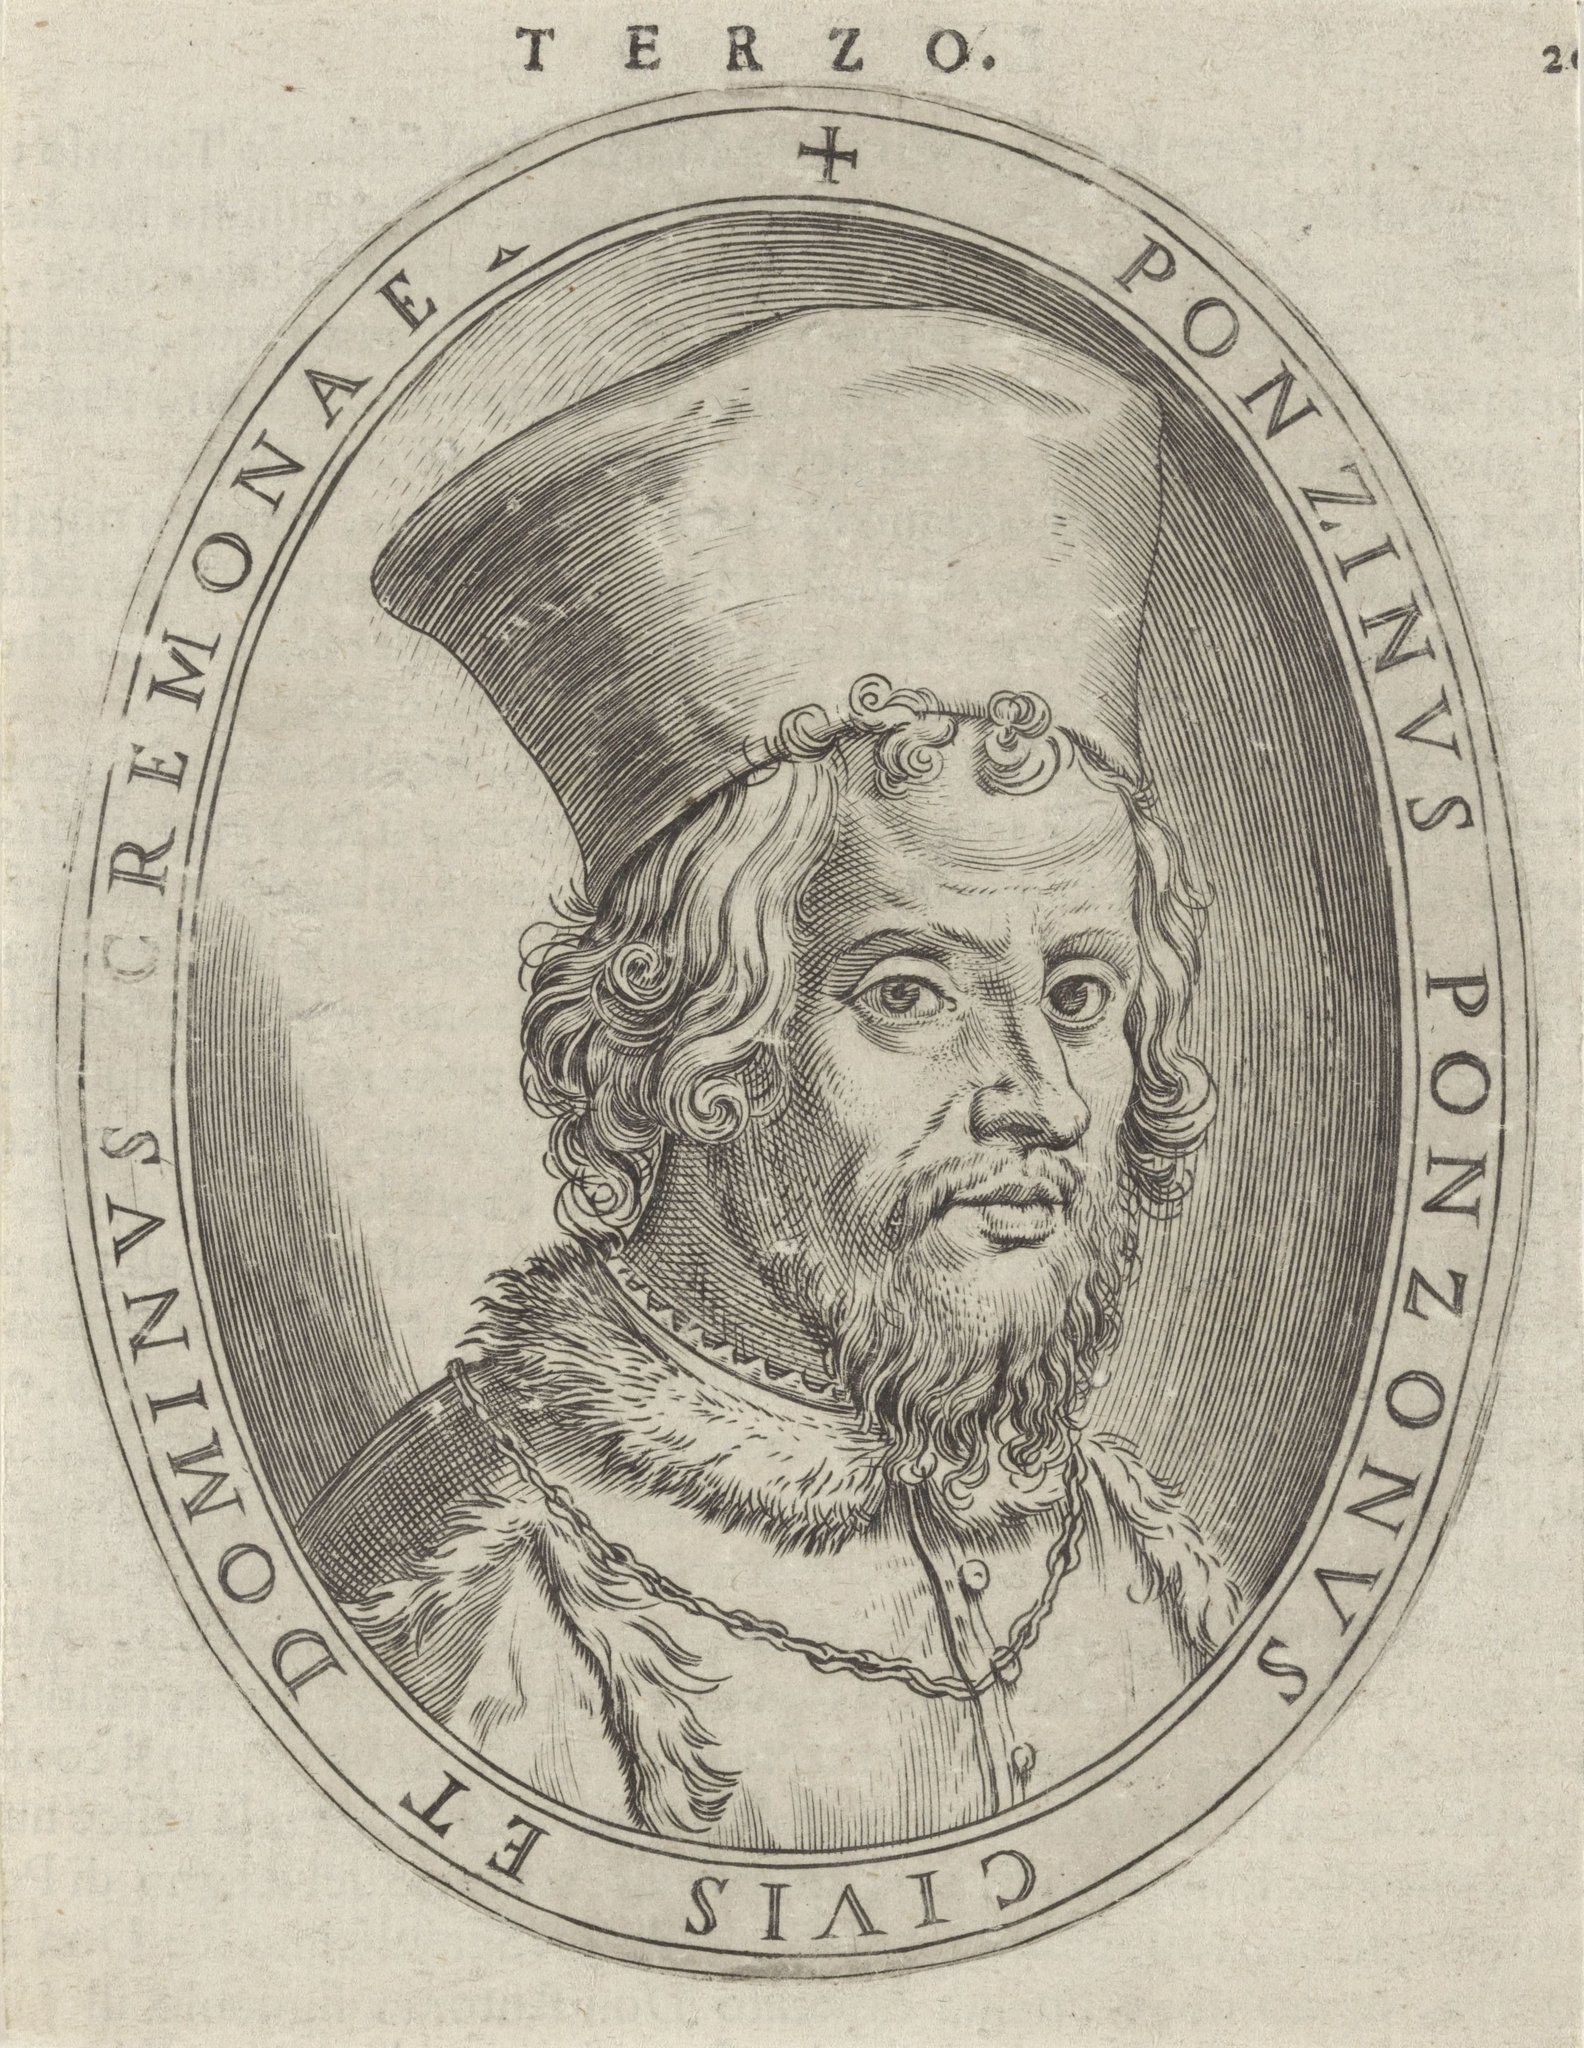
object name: print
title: Portret van Ponzino Ponzoni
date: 1585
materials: paper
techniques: engraving, letterpress printing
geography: milan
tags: historical persons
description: Prent uit Antonio Campo, Cremona fedelissima citta, et nobilissima colonia de Romani rappresentata in disegno col suo contado; et illustrata d'una breve historia, Milaan: Filippo Ghisolfi 1642, vol. 3, p. lviij.